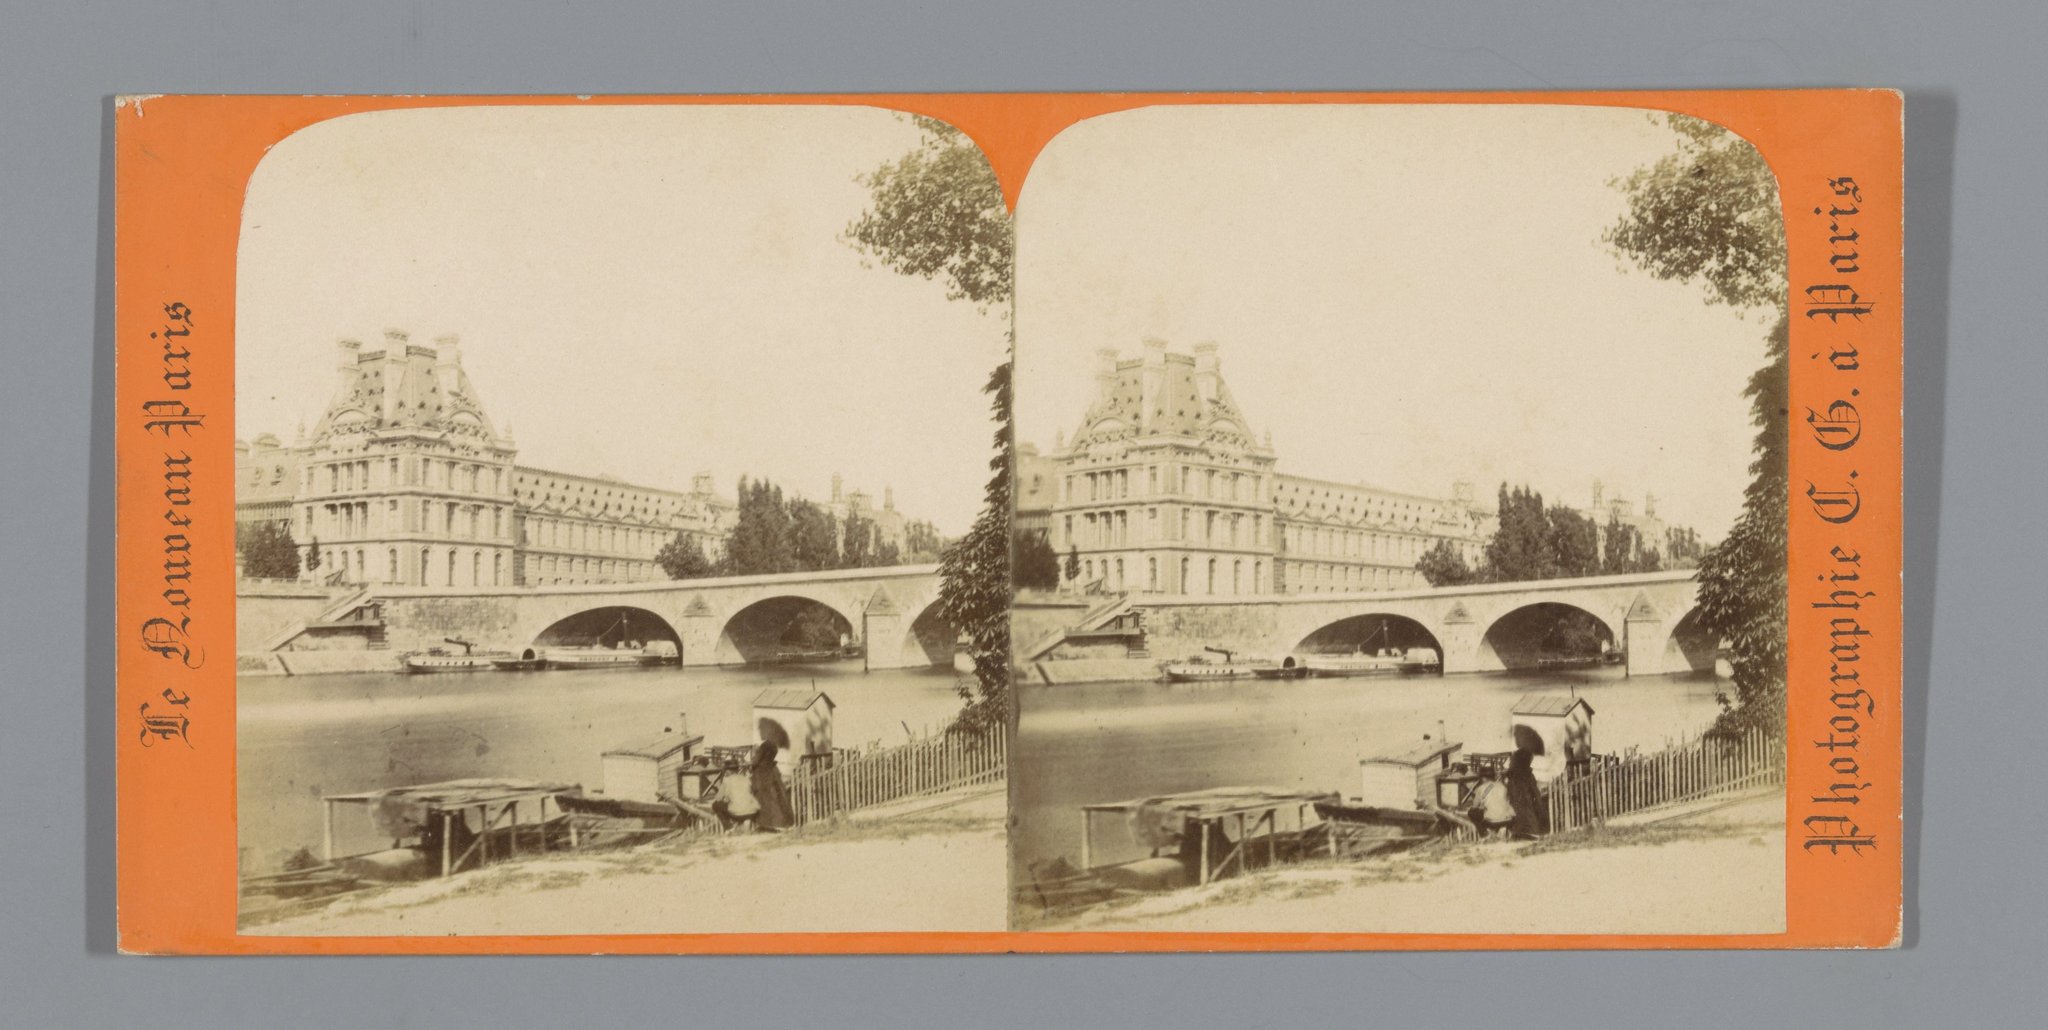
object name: stereograph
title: Gezicht op een brug over de Seine te Parijs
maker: charles gérard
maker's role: fotograaf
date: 1850-1875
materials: cardboard, photographic support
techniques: albumen print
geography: paris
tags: bridge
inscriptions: inscription: ‘Les Tuileries’